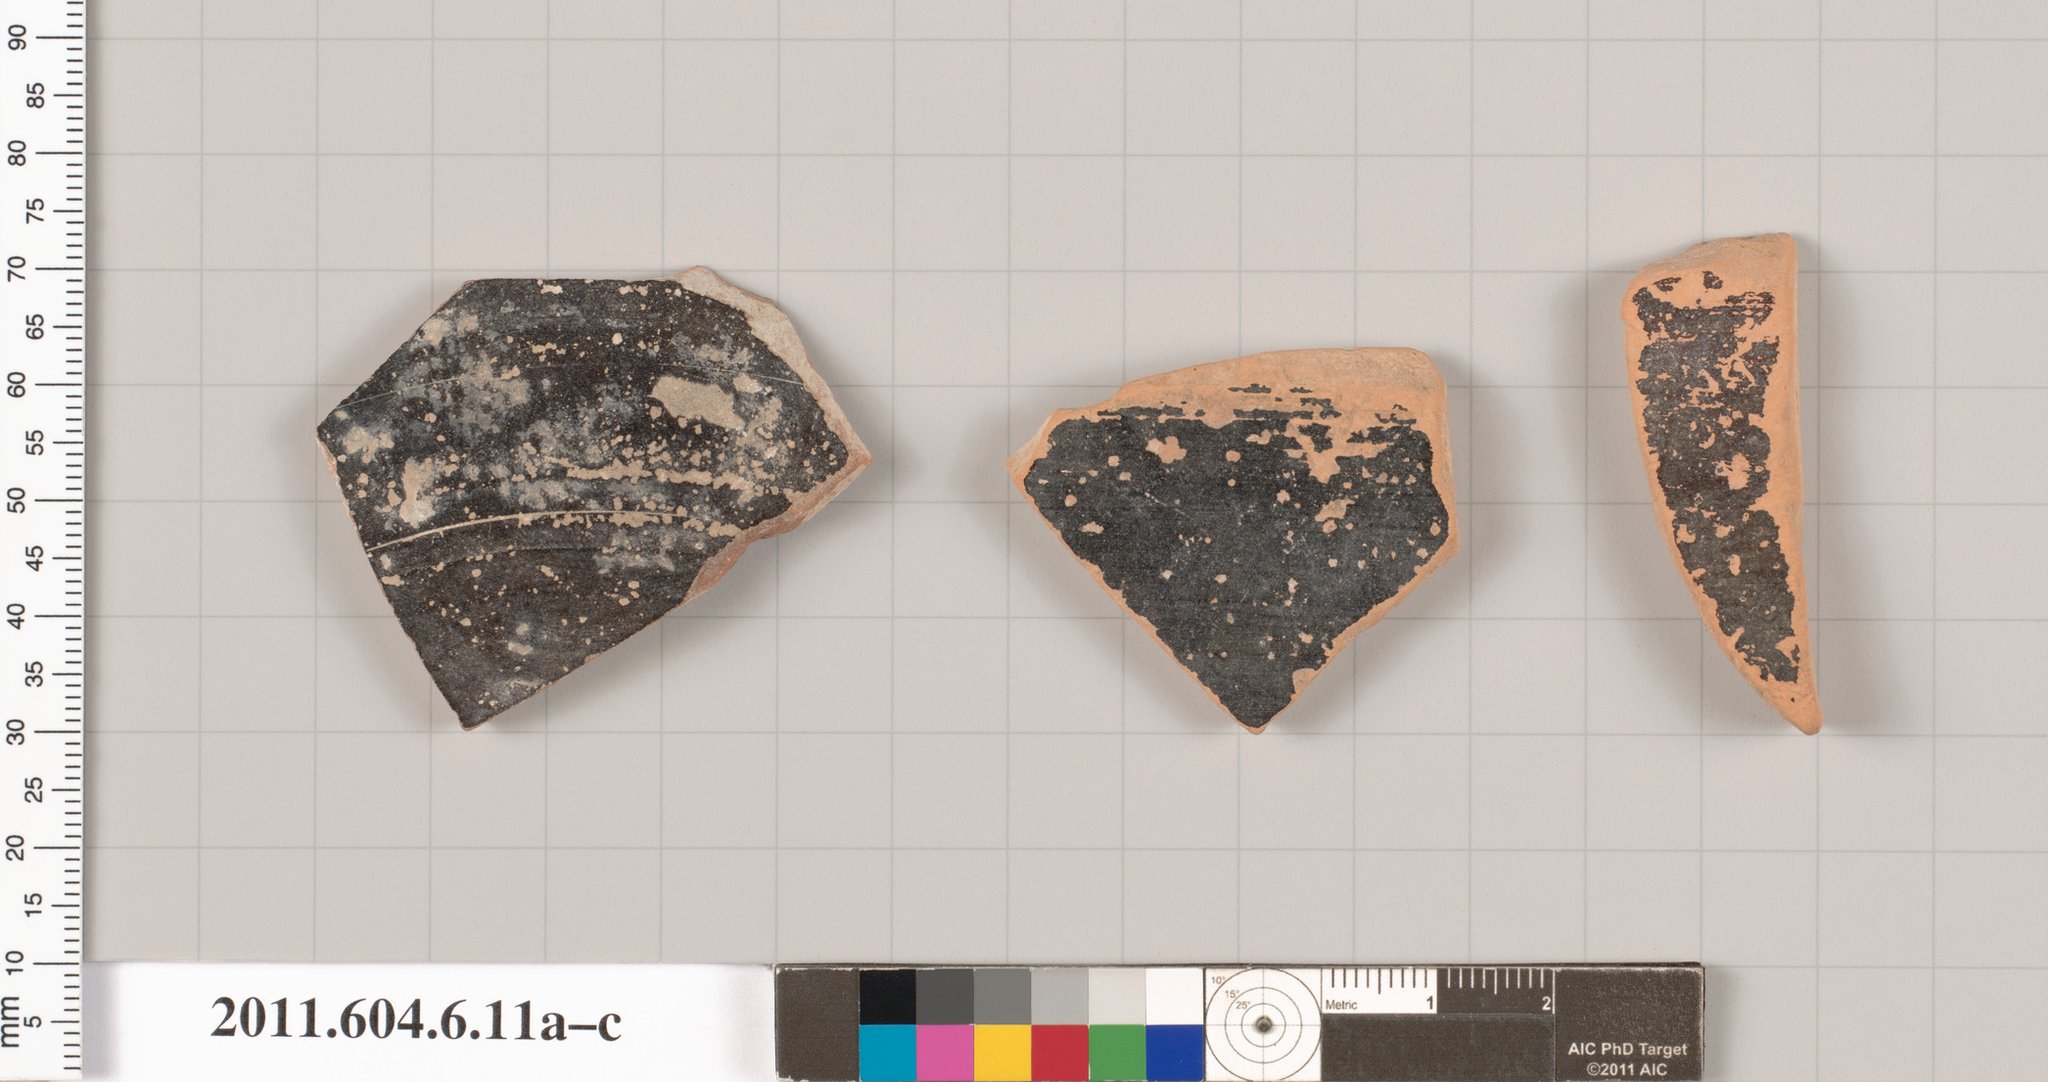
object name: undetermined open shape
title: Terracotta fragments of open shapes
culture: greek, attic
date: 600-401 BCE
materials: terracotta